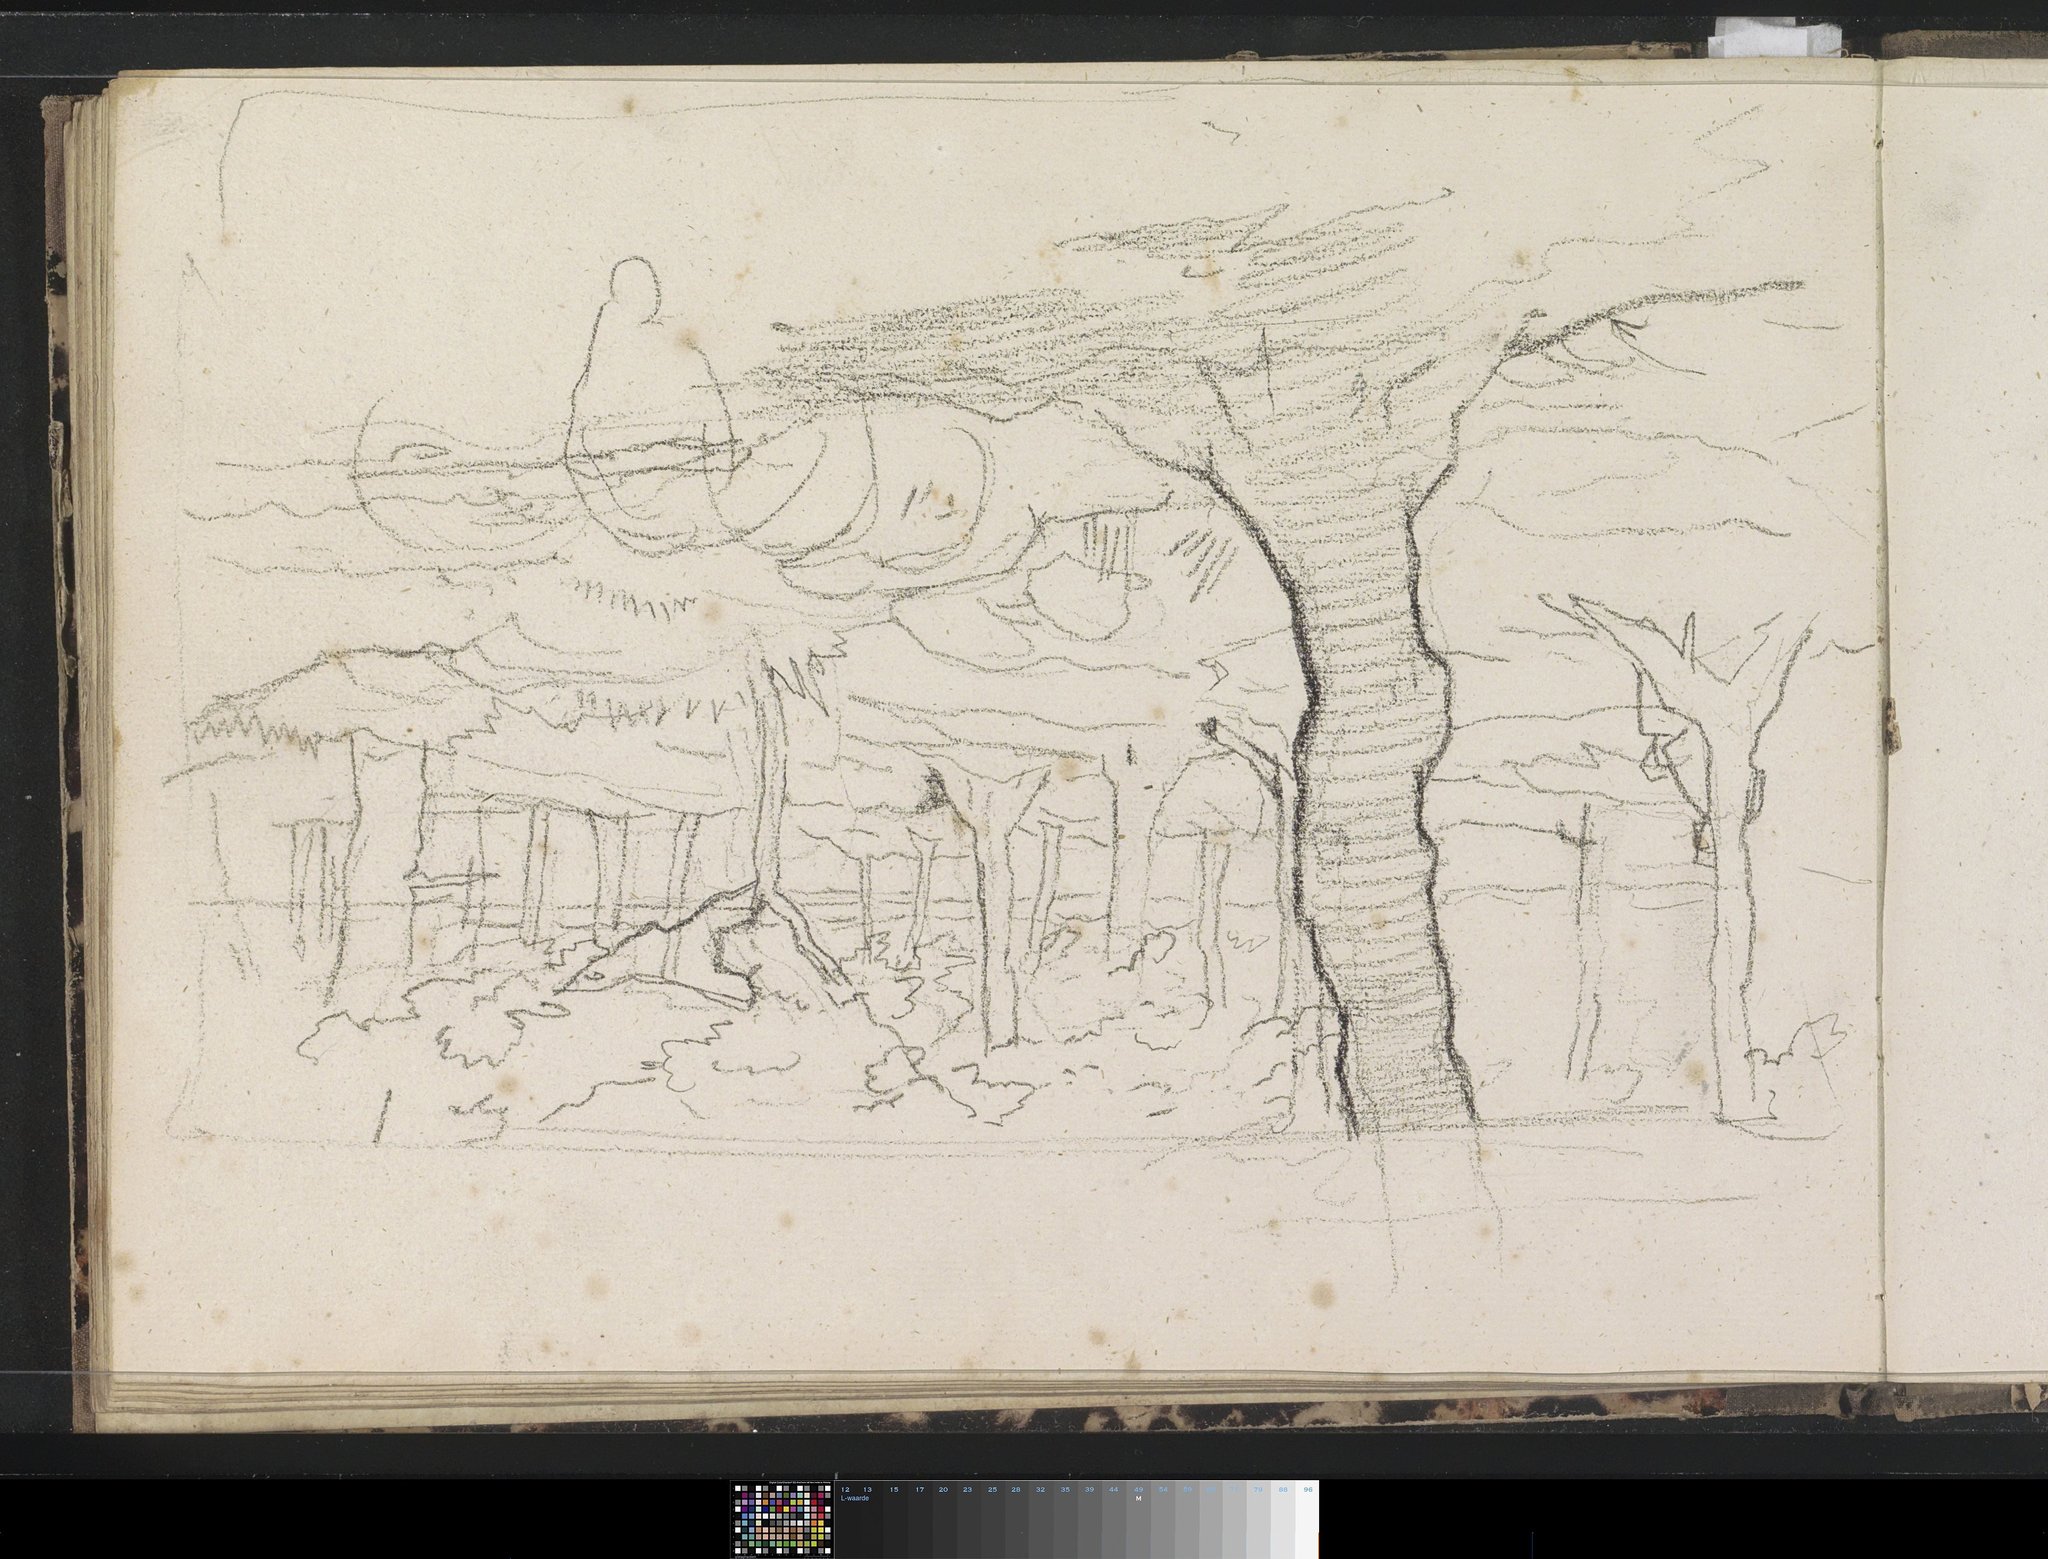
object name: sketchbook leaf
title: Landschap met bomen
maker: anton mauve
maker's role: draughtsman, painter, print maker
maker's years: 1838-1888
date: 1848-1888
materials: chalk, paper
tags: trees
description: Blad 33 verso uit een schetsboek met 34 bladen.